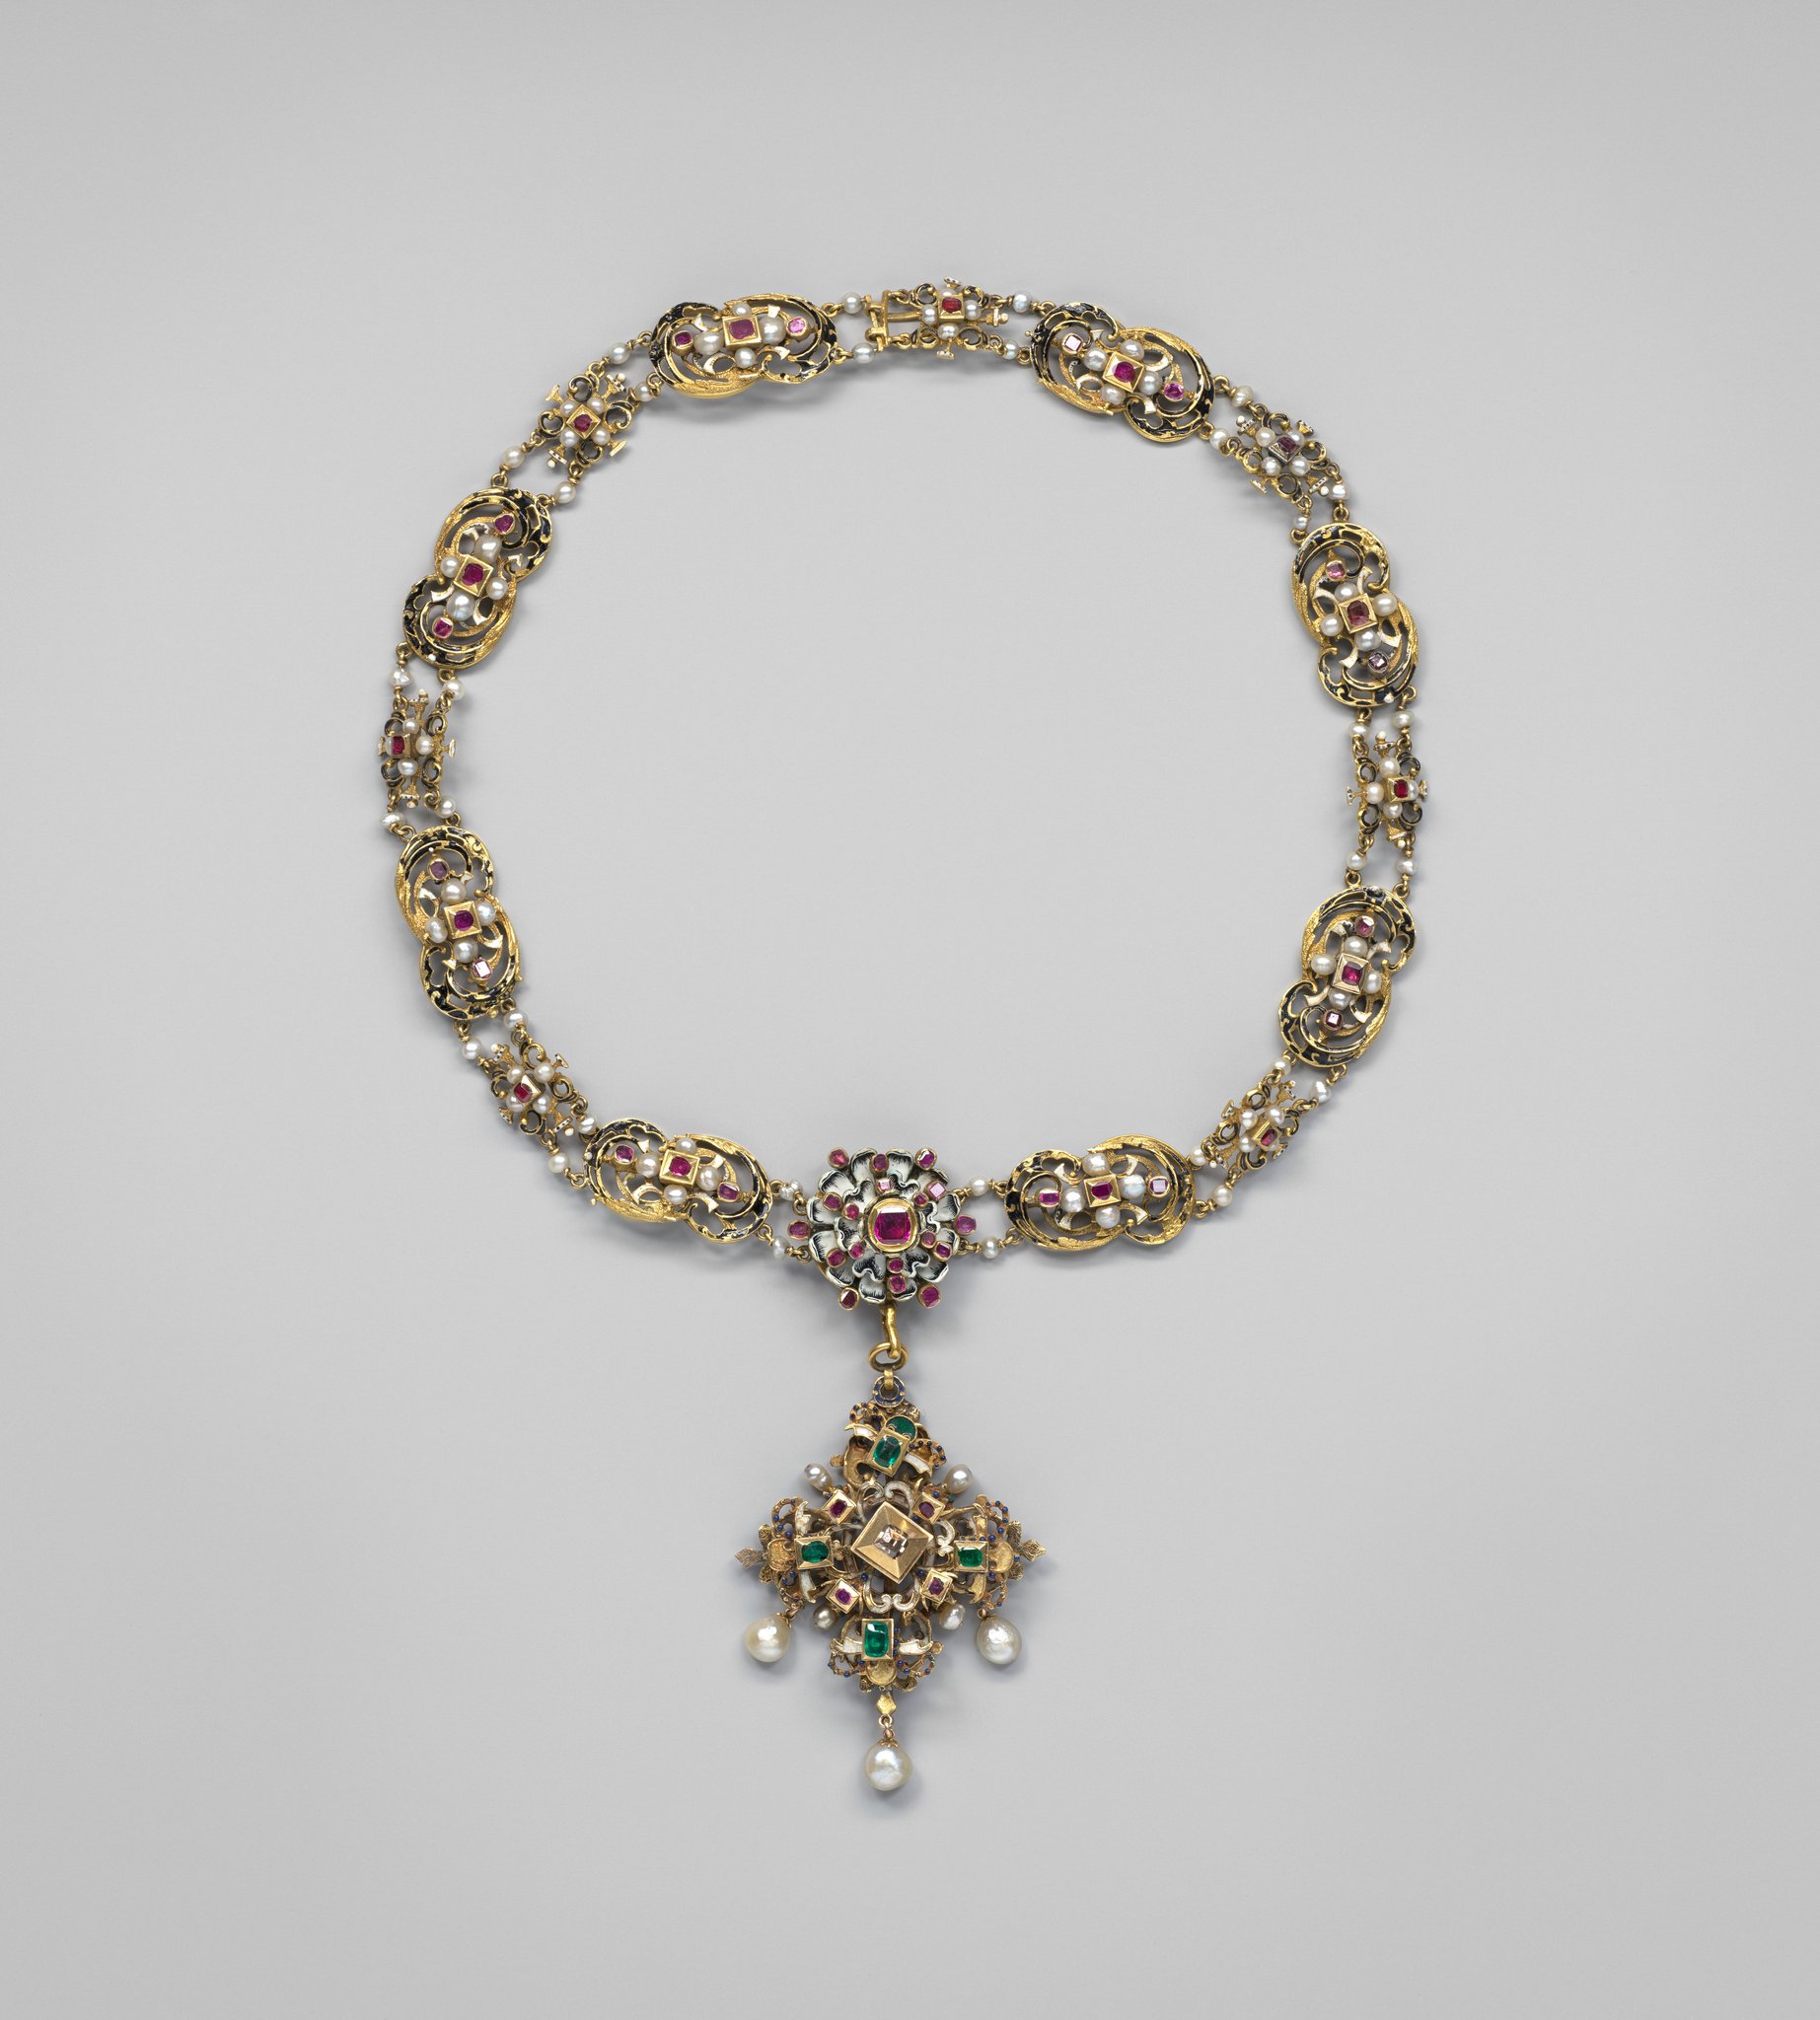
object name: necklace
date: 1601-1633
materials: enamel, gold, pearl, gemstone, stone